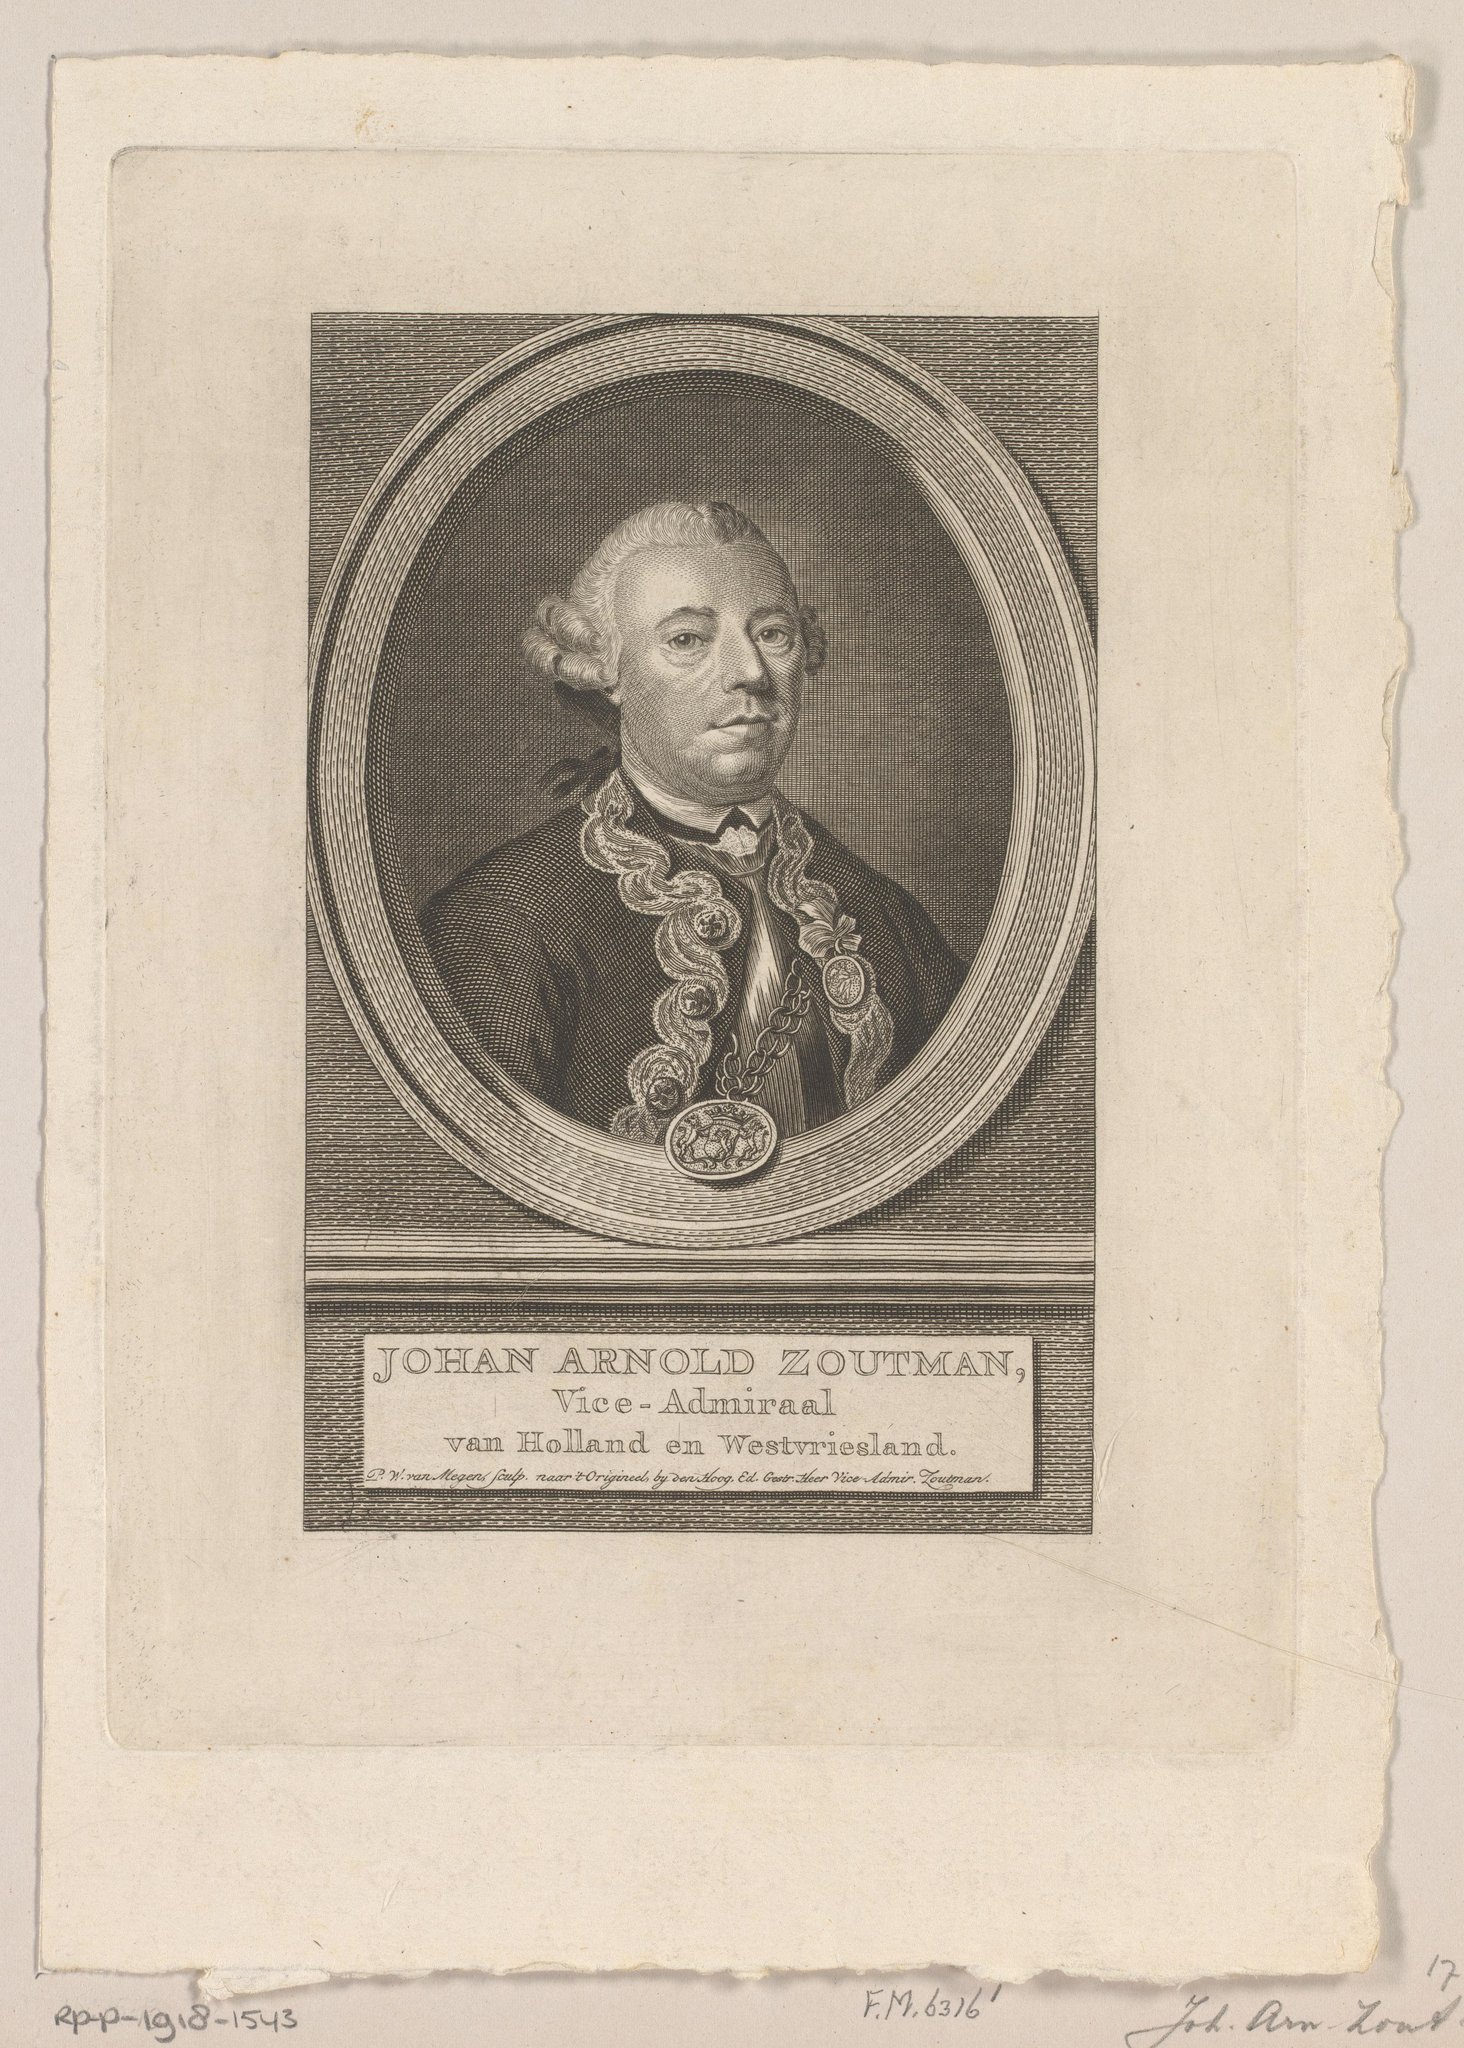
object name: print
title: Portret van Johan Arnold Zoutman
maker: pieter willem van megen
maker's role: print maker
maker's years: 1750-1785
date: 1776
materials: paper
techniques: engraving, etching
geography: the hague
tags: the hague, johan arnold zoutman, historical persons, baton of general, commander-in-chief, admiral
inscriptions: collector's mark: Lugt 2233, number: ‘'18 / 1543’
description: Prent waarschijnlijk uit: Nomsz., Johannes. Mengelwerk. Amsterdam: s.n., 1776, dl. 3.